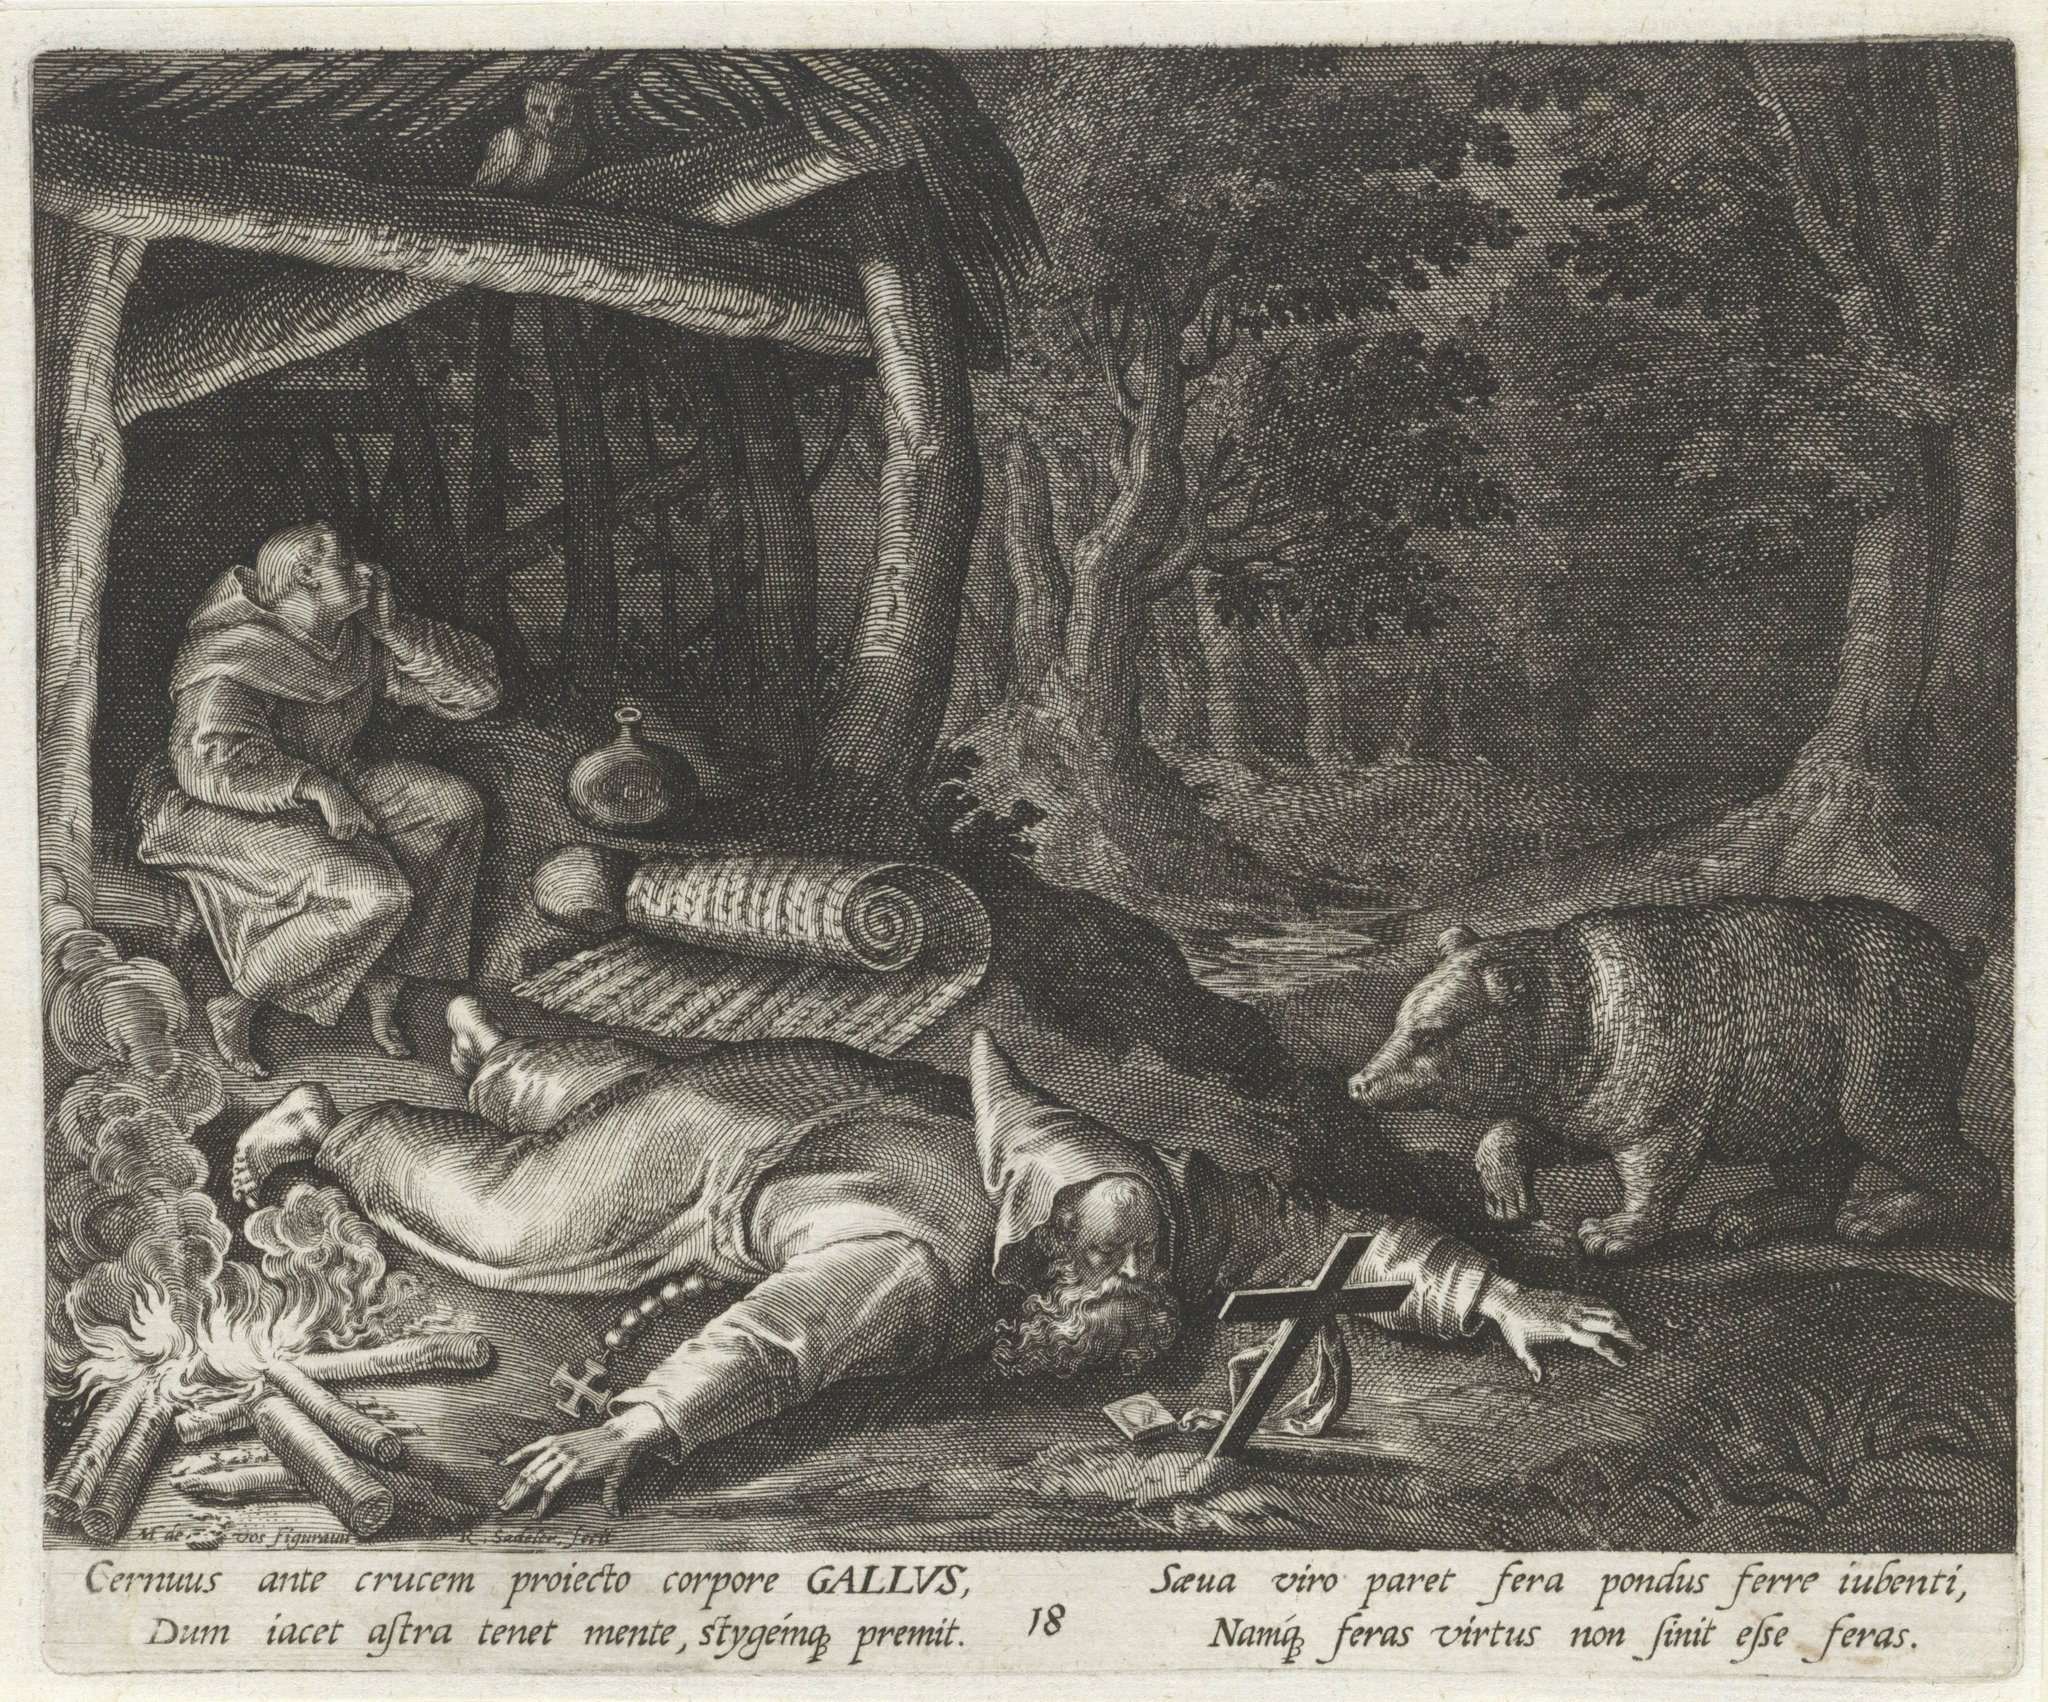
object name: print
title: Sylvae Sacrae Monumenta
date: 1594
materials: paper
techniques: engraving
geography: munich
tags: monk(s), friar(s), beasts of prey, predatory animals: bear, forest, wood, anchorite, hermit, hut, cabin, lodge, the monk and hermit gall(us); possible attributes: bear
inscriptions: collector's mark: Lugt 240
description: De H. Gallatius van Helvetië, een Ierse missionaris en kluizenaar, ligt op de grond naast een hut in een bos. Hij bidt tot God voor een crucifix. Zijn attribuut, een beer, naast hem. In de kluizenaarshut zit een andere monnik te slapen.